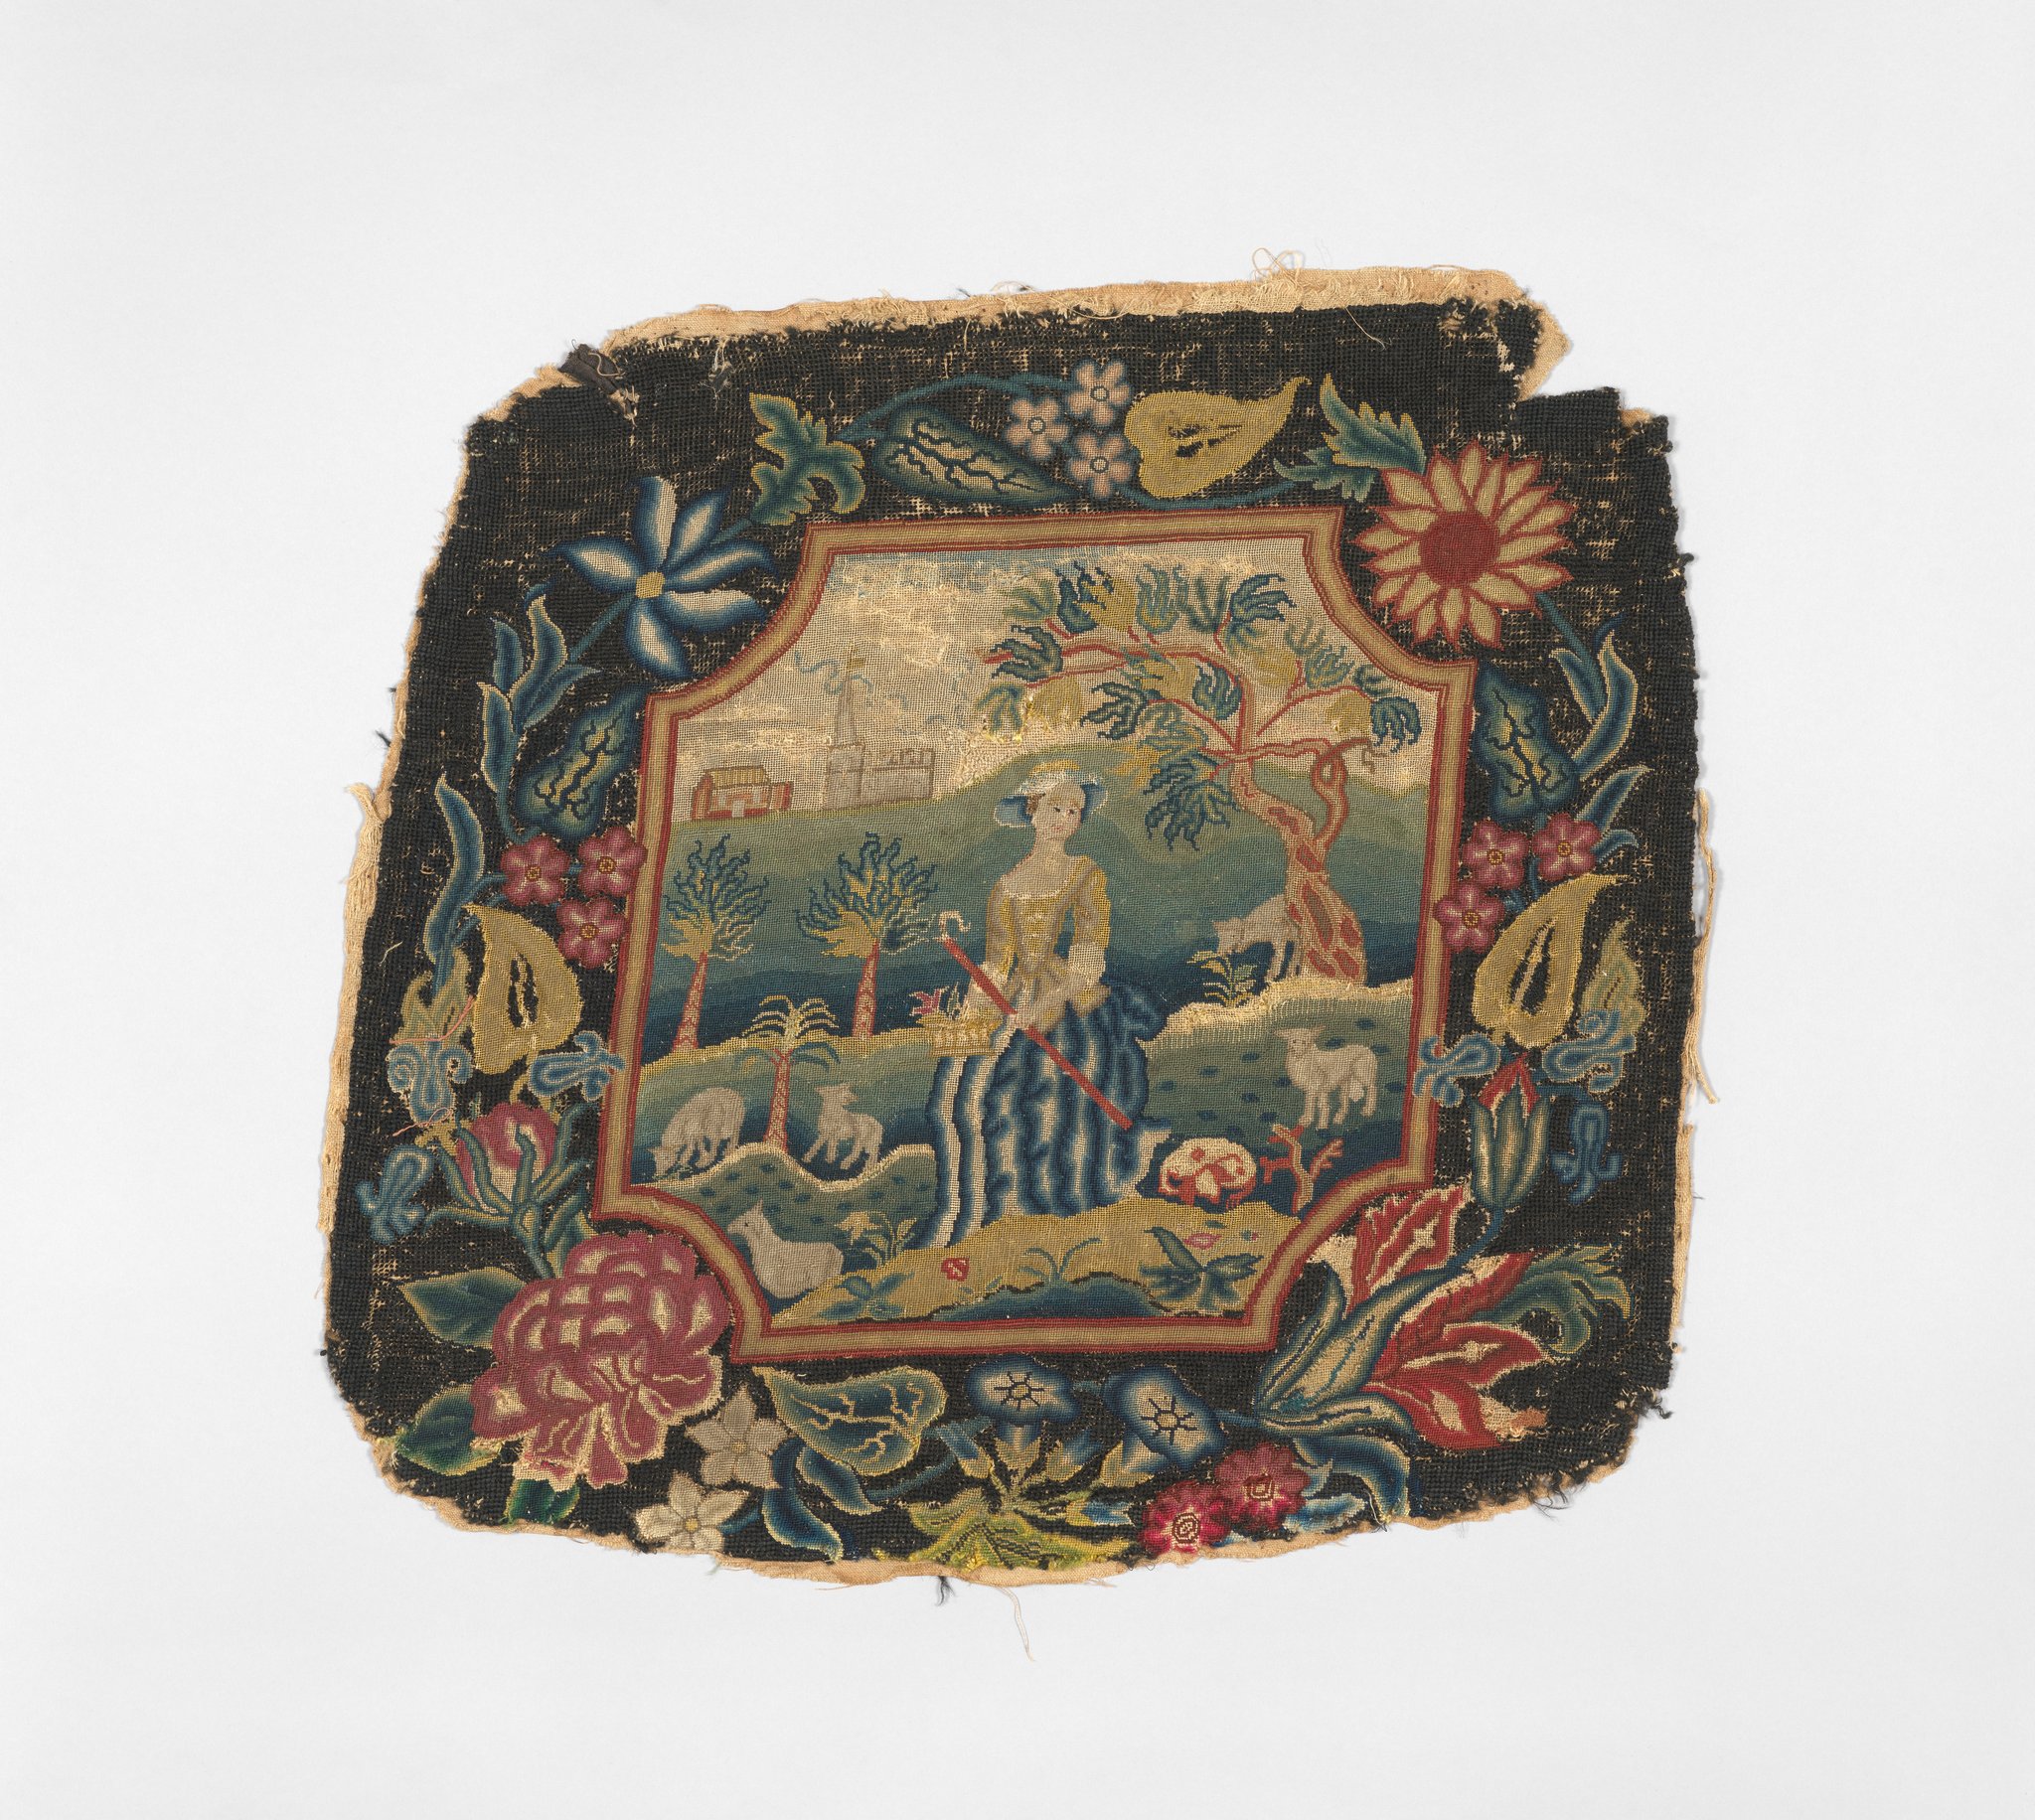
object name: cover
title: Chair seat cover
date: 1734-1766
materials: canvas, silk, wool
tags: women,lambs